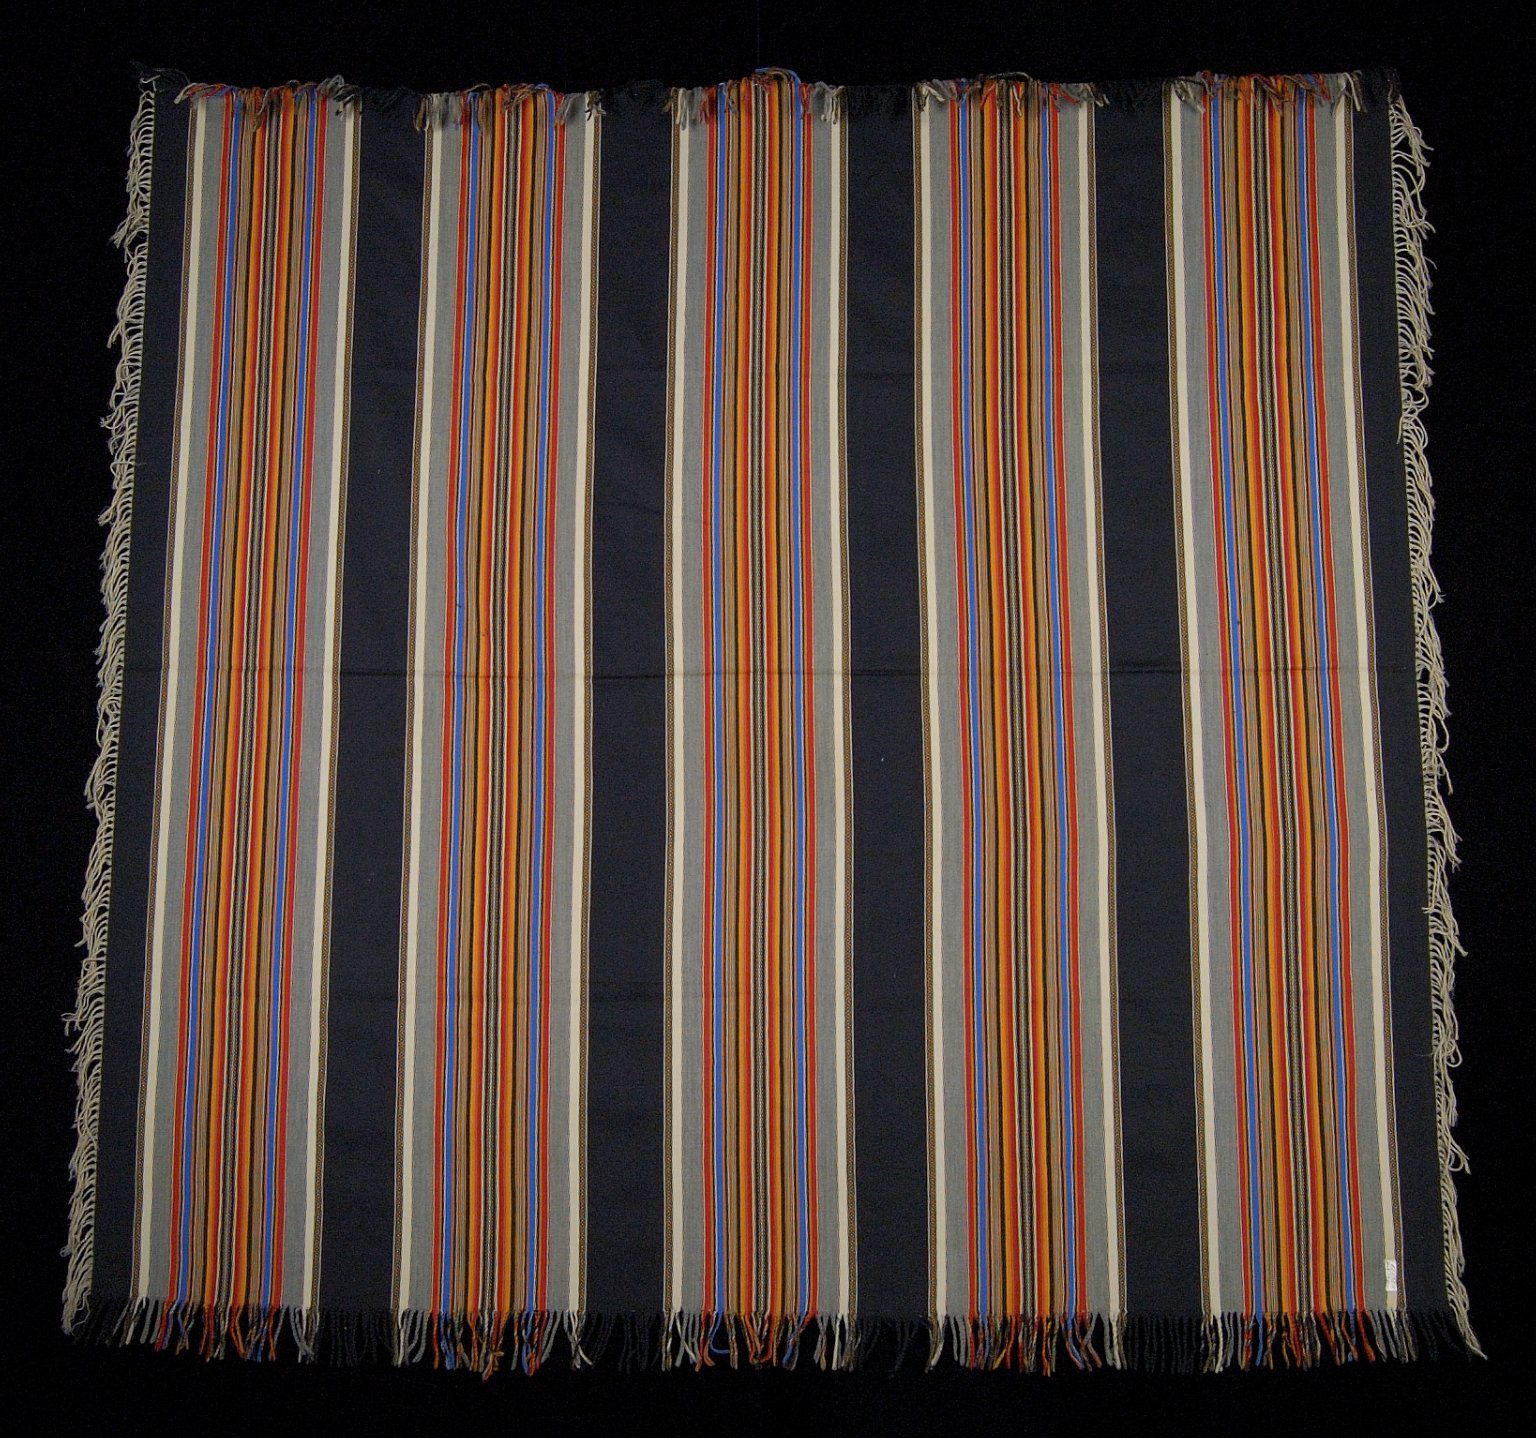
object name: shawl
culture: american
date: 1851-1875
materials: wool